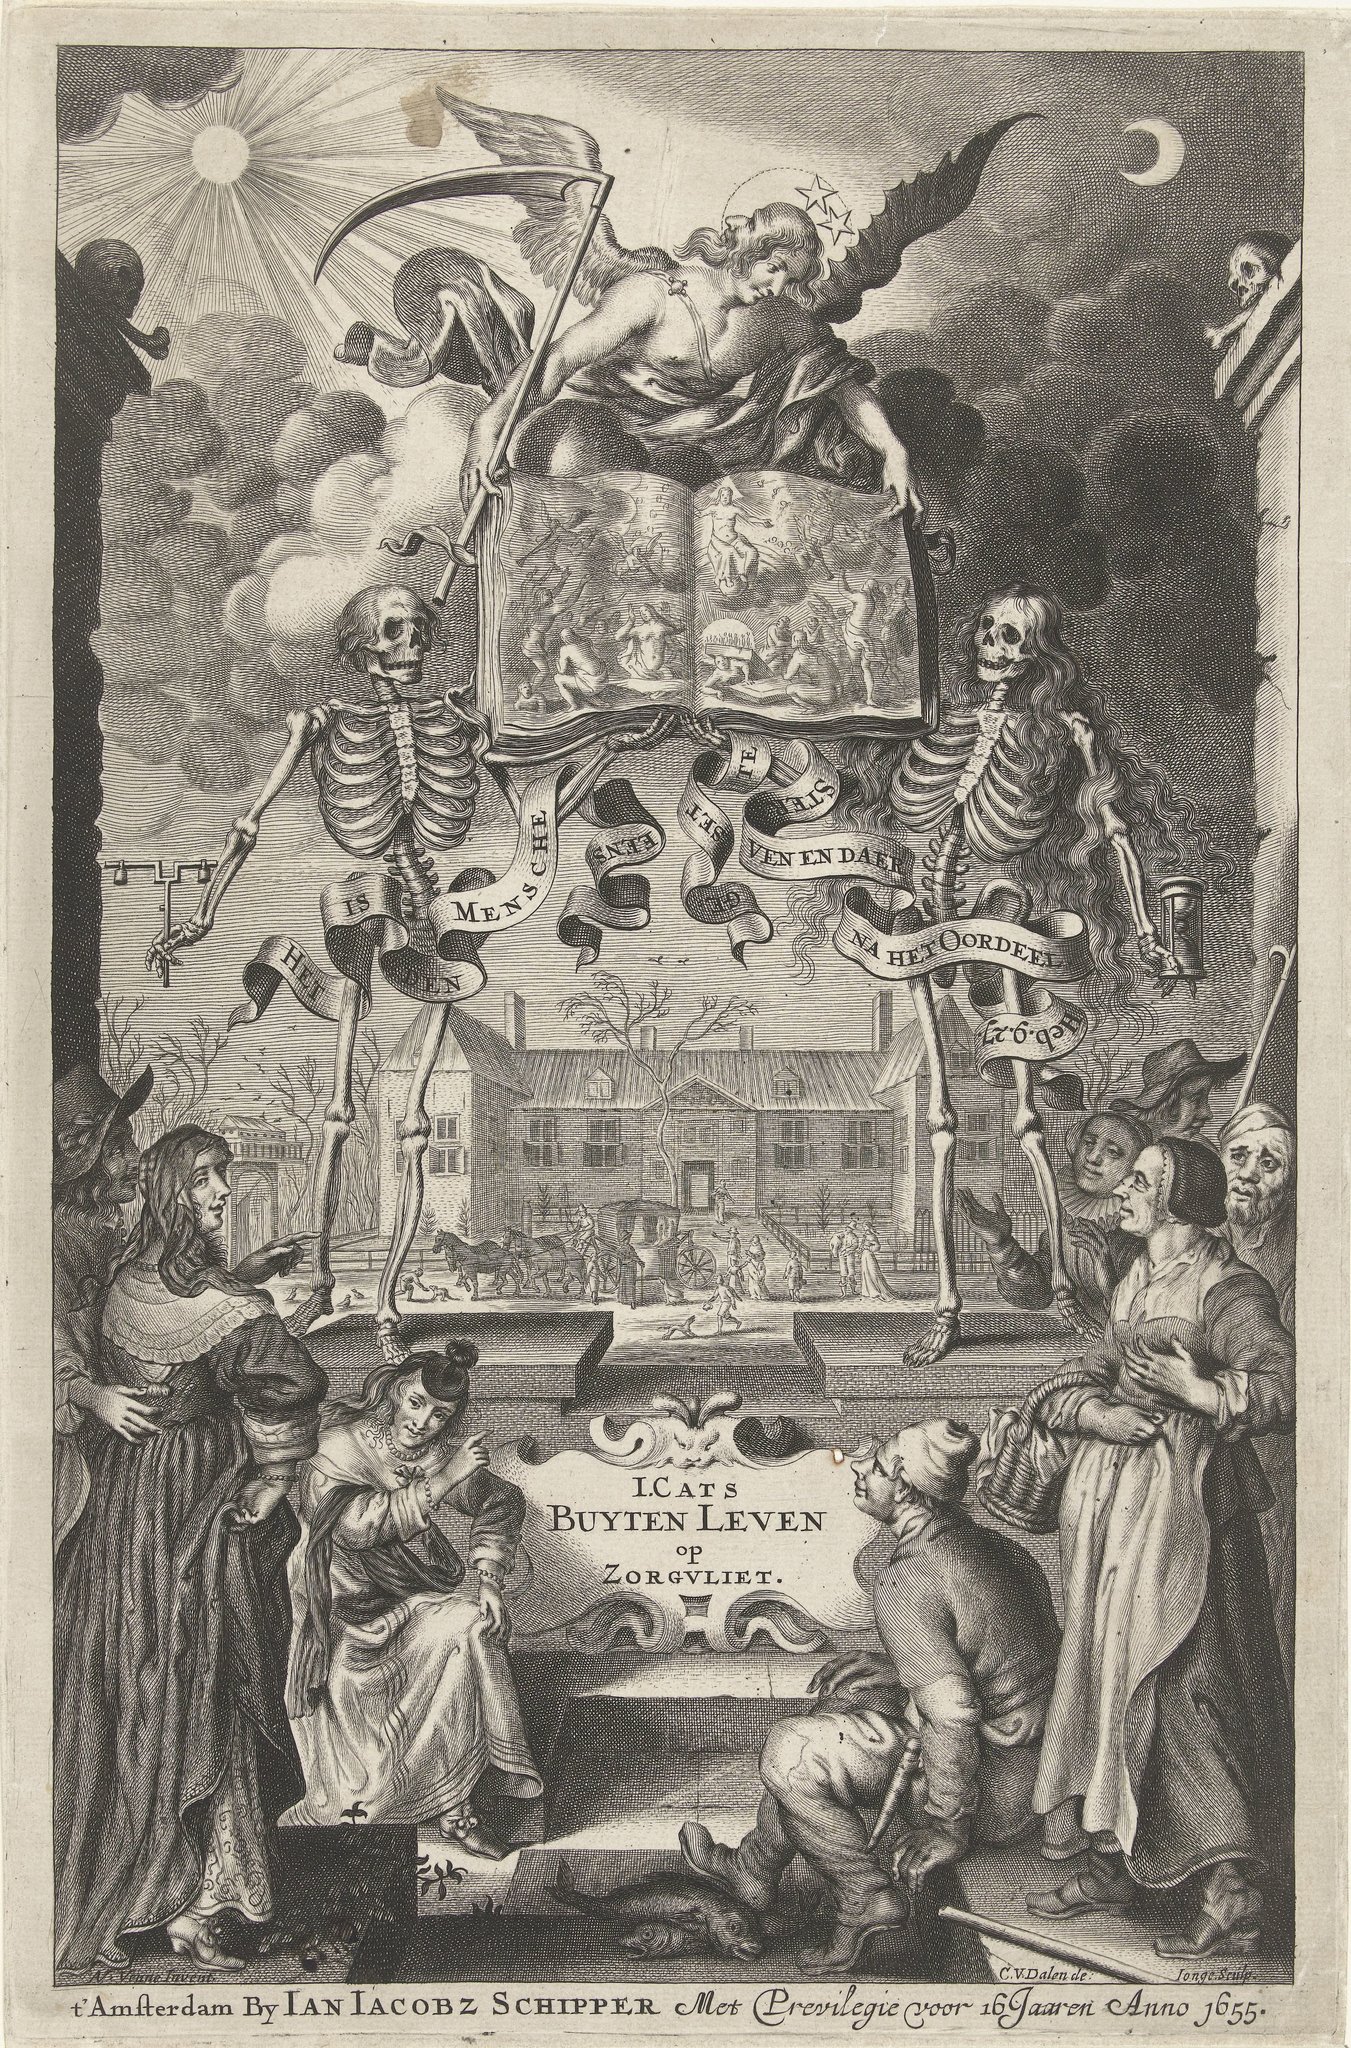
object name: print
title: Stadsmensen en boeren kijken naar twee skeletten en engel met boek opengeslagen bij voorstelling van laatste oordeel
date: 1655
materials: paper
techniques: engraving, etching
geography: amsterdam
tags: last judgement, life versus death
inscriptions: collector's mark: Lugt 2228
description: Stadsmensen en boeren kijken naar twee skeletten en engel met boek opengeslagen bij voorstelling van laatste oordeel. Hen wordt met het laatste oordeel in het vooruitzicht, aangeraden om deugdzaam te leven. Op de achtergrond een landschap met groot huis waar stadsmensen zich buiten de stad eenvoudig en deugdzaam vermaken, het onderwerp van de hofdichten in de uitgave. Op een banderol bij de skeletten staat een tekst uit Hebreeën 9:27.